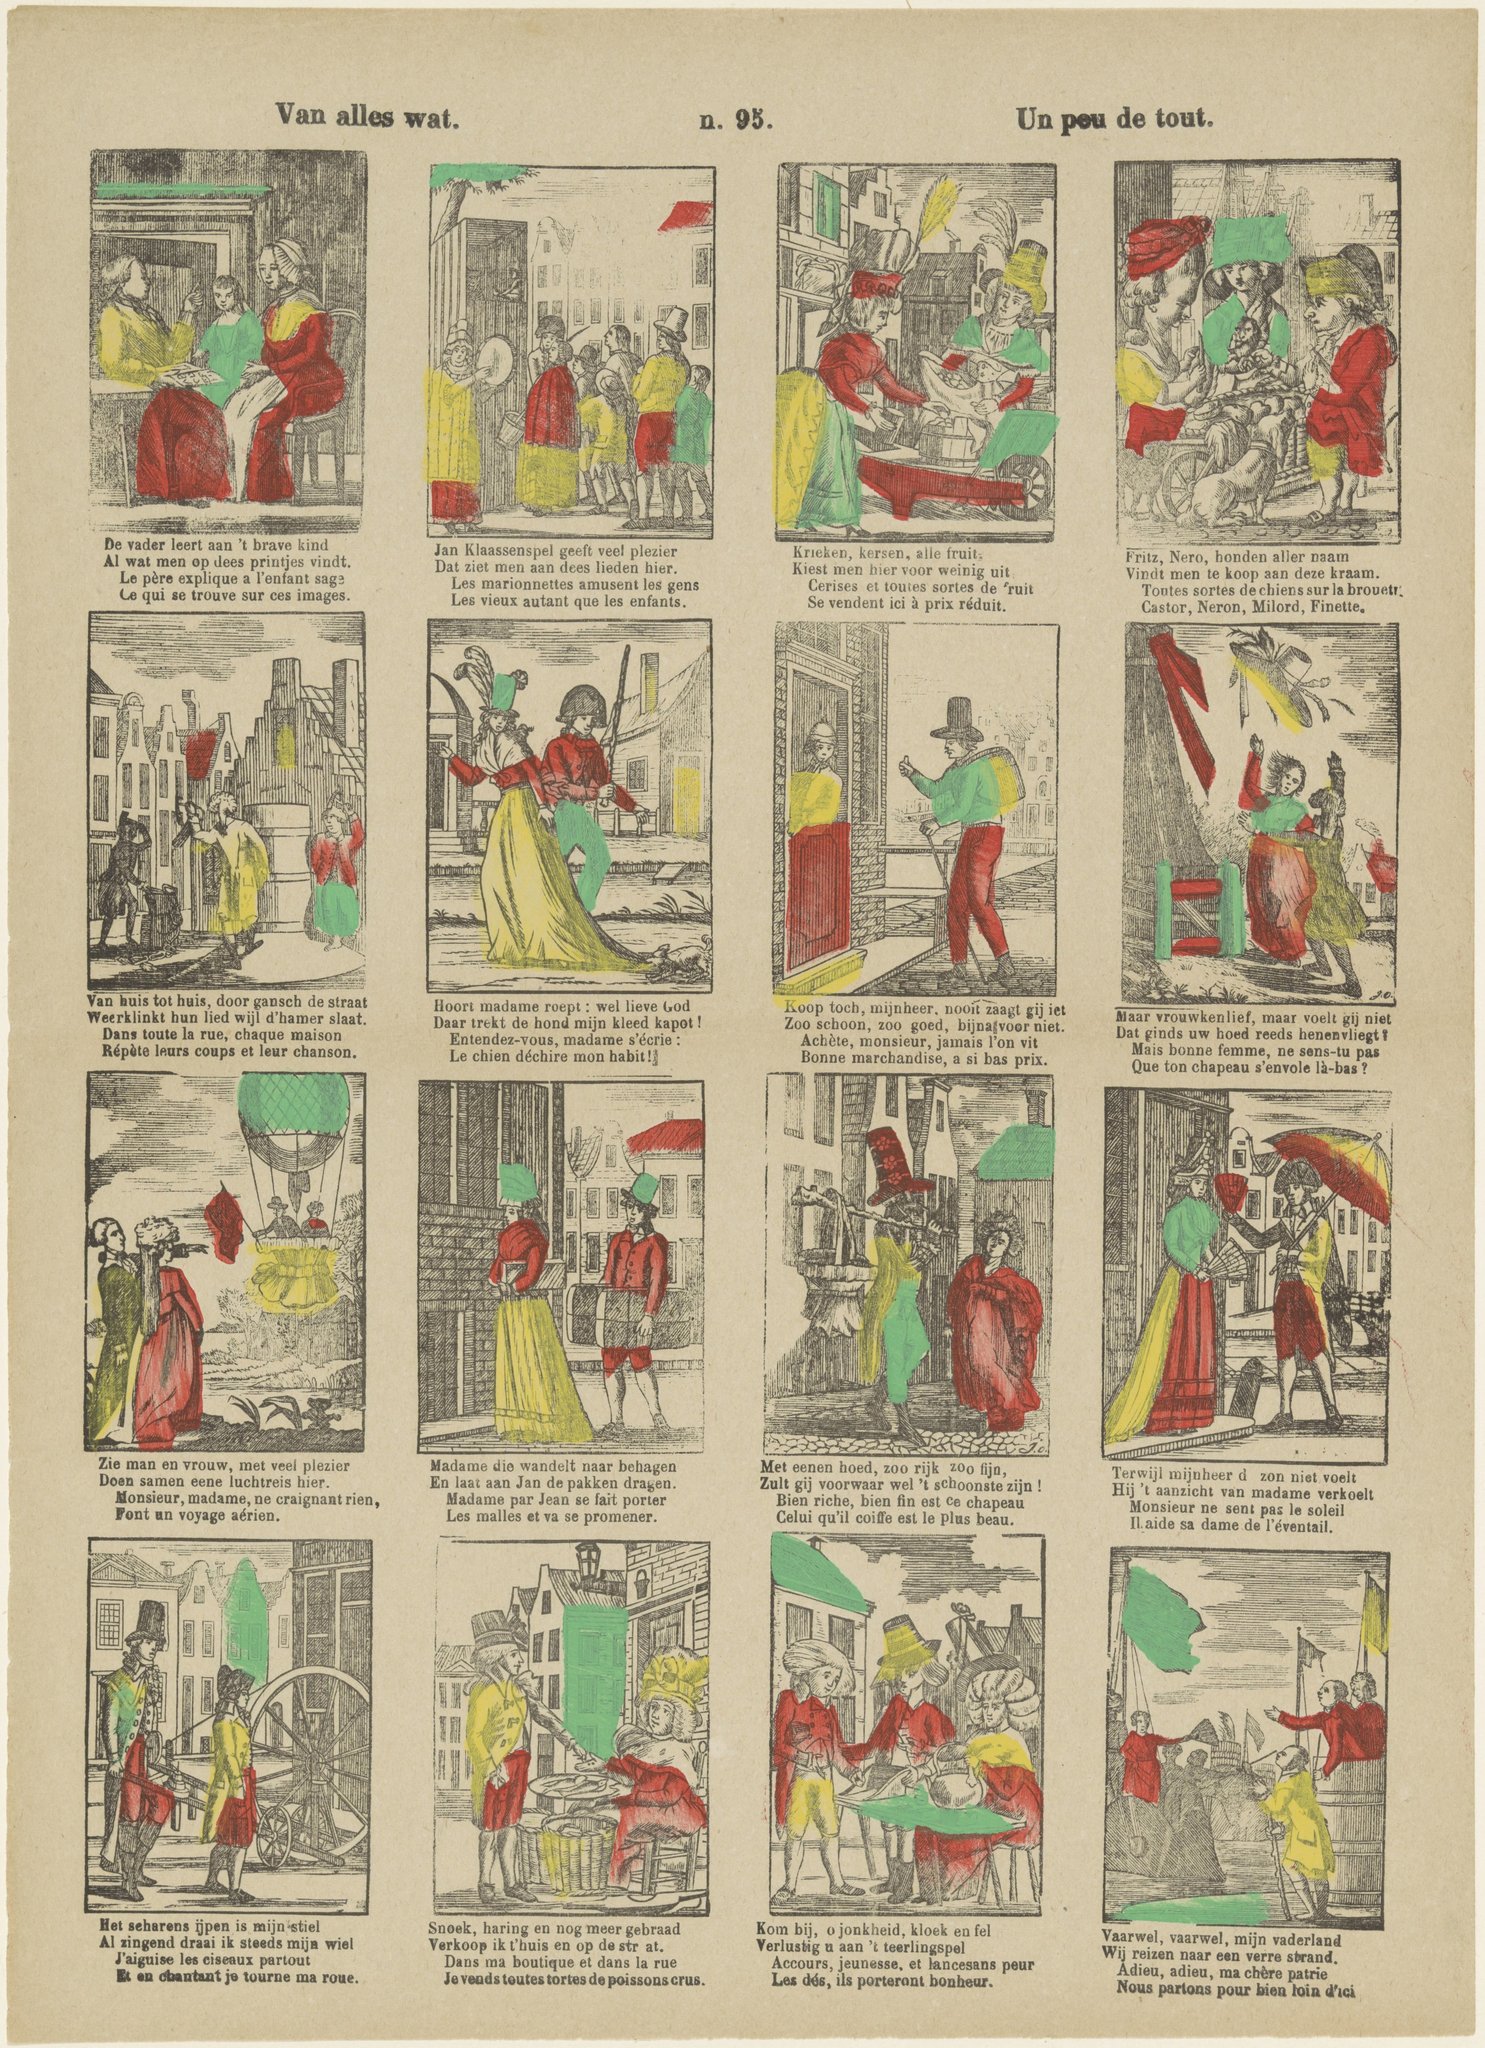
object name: print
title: Van alles wat / Un peu de tout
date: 1866-1902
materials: paper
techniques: colour, letterpress printing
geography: turnhout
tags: (flying a) gas balloon, street-trader, crafts and industries, merchant, salesman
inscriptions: collector's mark: Lugt 2760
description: Blad met 16 voorstellingen van verschillende aard, waaronder een fruitverkoopster, een luchtballonvaart en een scharenslijper. Onder elke afbeelding een tweeregelig vers in het Nederlands en in het Frans. Genummerd midden boven: n. 95.